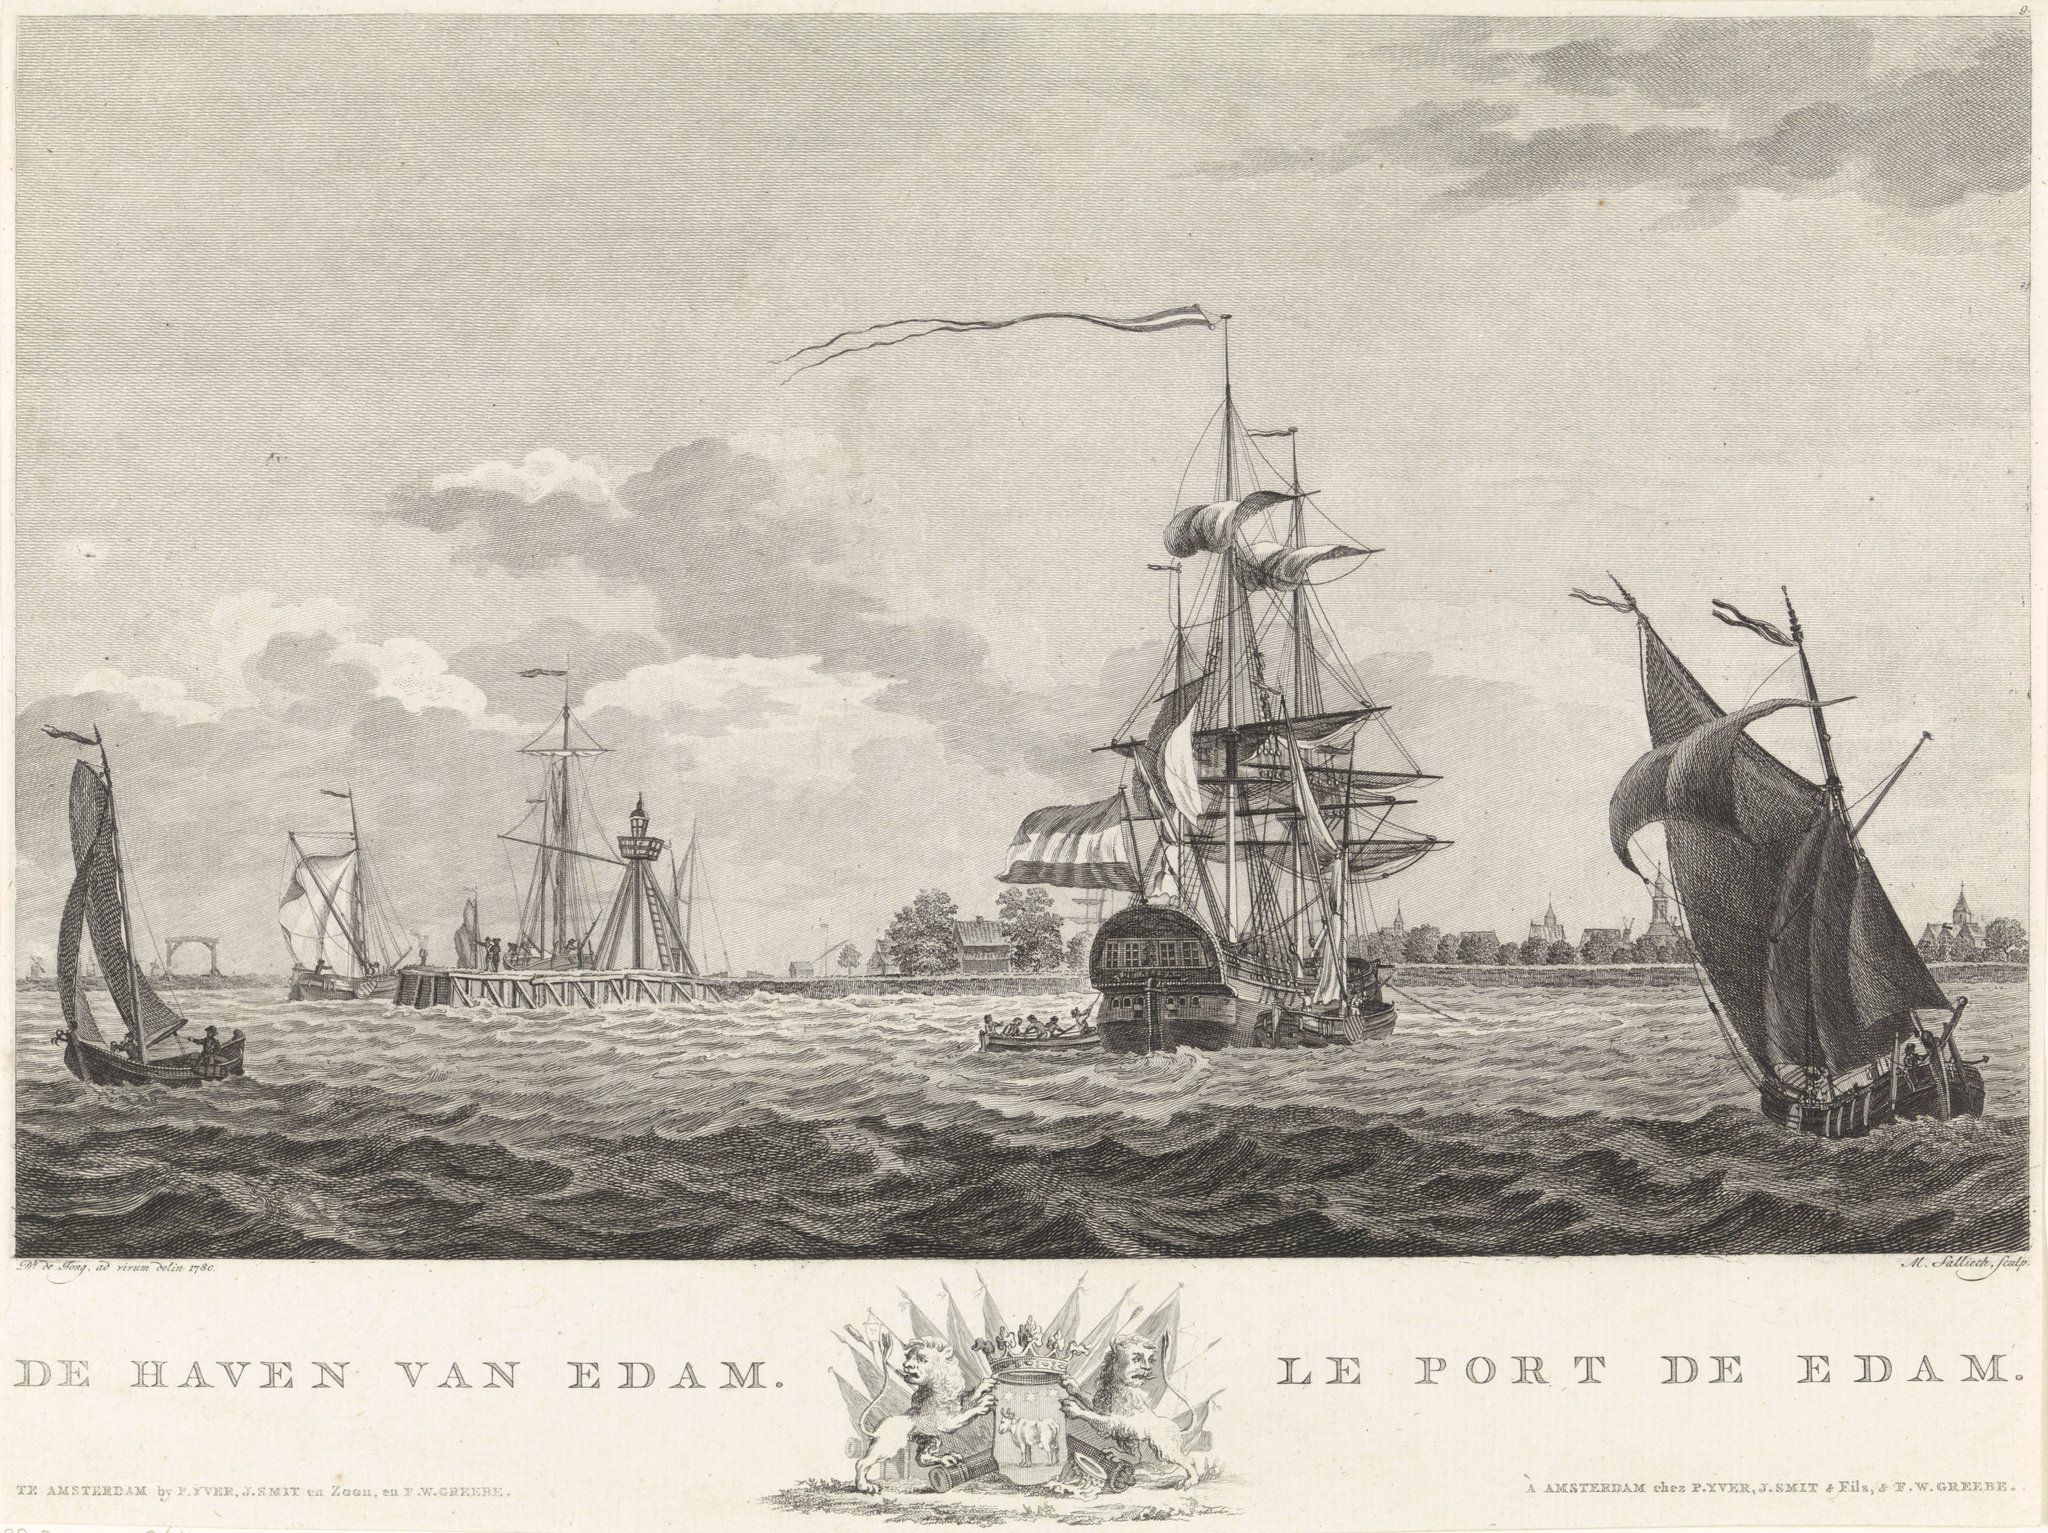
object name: print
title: Gezicht op de haven van Edam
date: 1780-1787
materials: paper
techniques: etching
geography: amsterdam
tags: harbour, coat of arms (as symbol of the state, etc.), coat of arms (as symbol of the state, etc.) (+ city; municipal), sailing-ship, sailing-boat, zuiderzee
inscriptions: collector's mark: Lugt 2228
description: Latere staat ook gebruikt in: Aa, Cornelis van der. Atlas van de zeehavens der Bataafsche Republiek. Met derzelver beschrijvingen in XXXI kunstplaaten / Atlas van de zeehavens der Bataafsche Republiek, die van Batavia en Onrust. Mitsgaders de afbeeldingen van de haringvisscherij en de walvischvangst […]. Amsterdam: Evert Maaskamp, 1805.